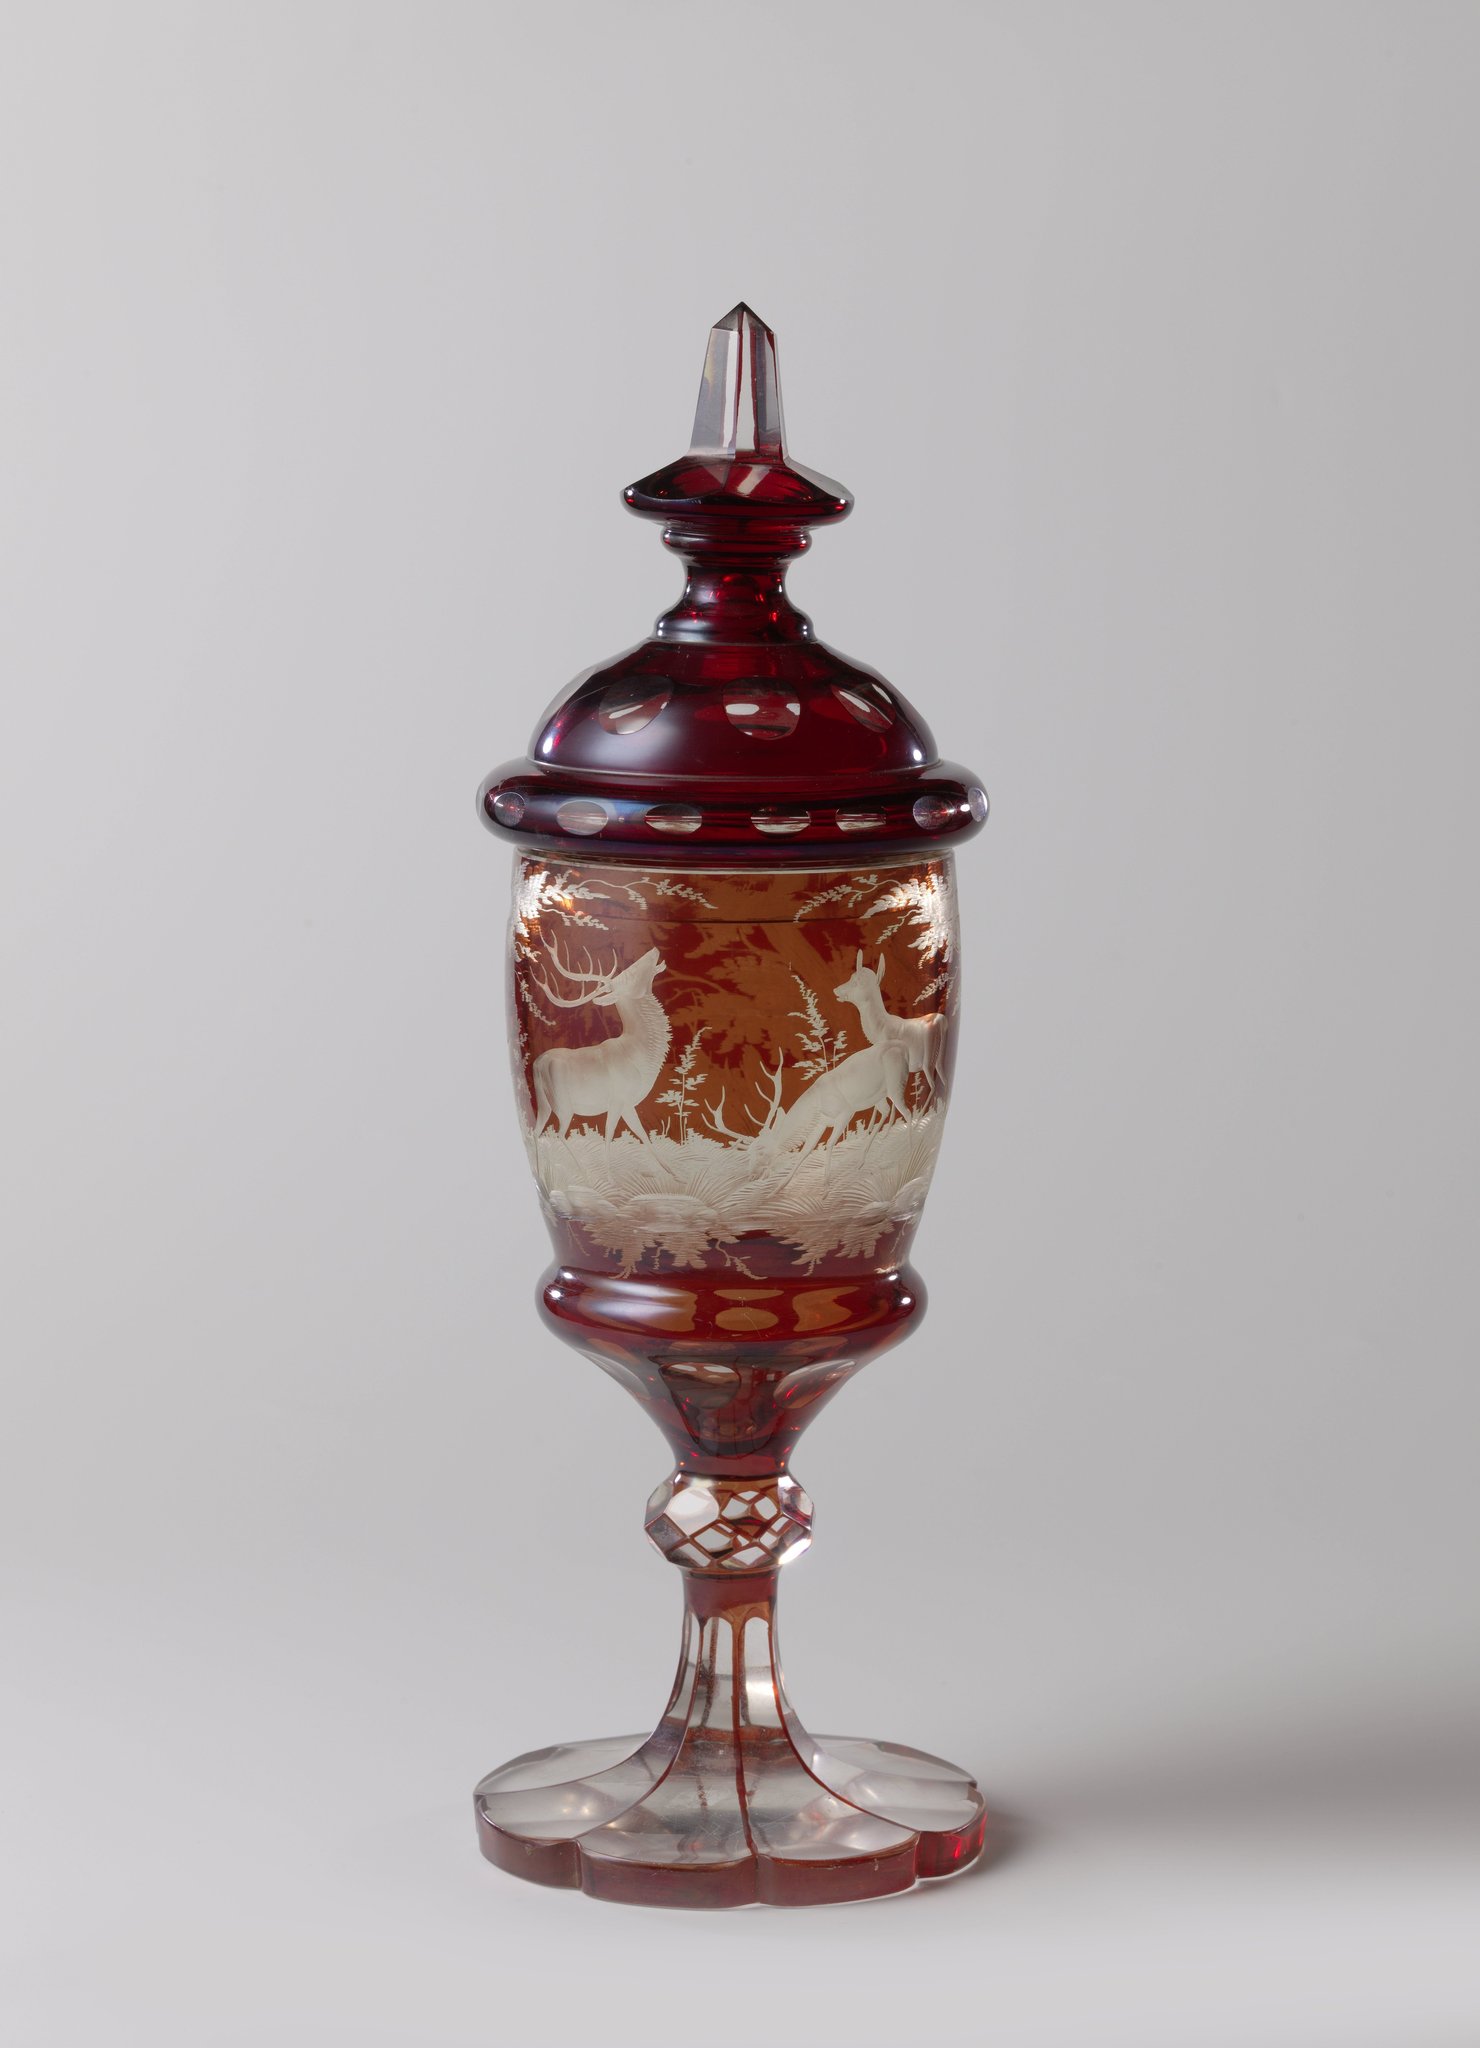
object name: goblet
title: Bokaal met deksel, met een bosgezicht met drie herten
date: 1920-1940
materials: glass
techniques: glassblowing, grinding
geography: steinschönau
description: Platte, achtlobbige, gefacetteerde voet overgaande in een gefacetteerde stam en knoop. Convexe kelk met trechtervormige onderzijde. Op de kelk is een bosgezicht met drie herten gegraveerd. Op de onderzijde van de kelk geslepen ovalen en cirkels.